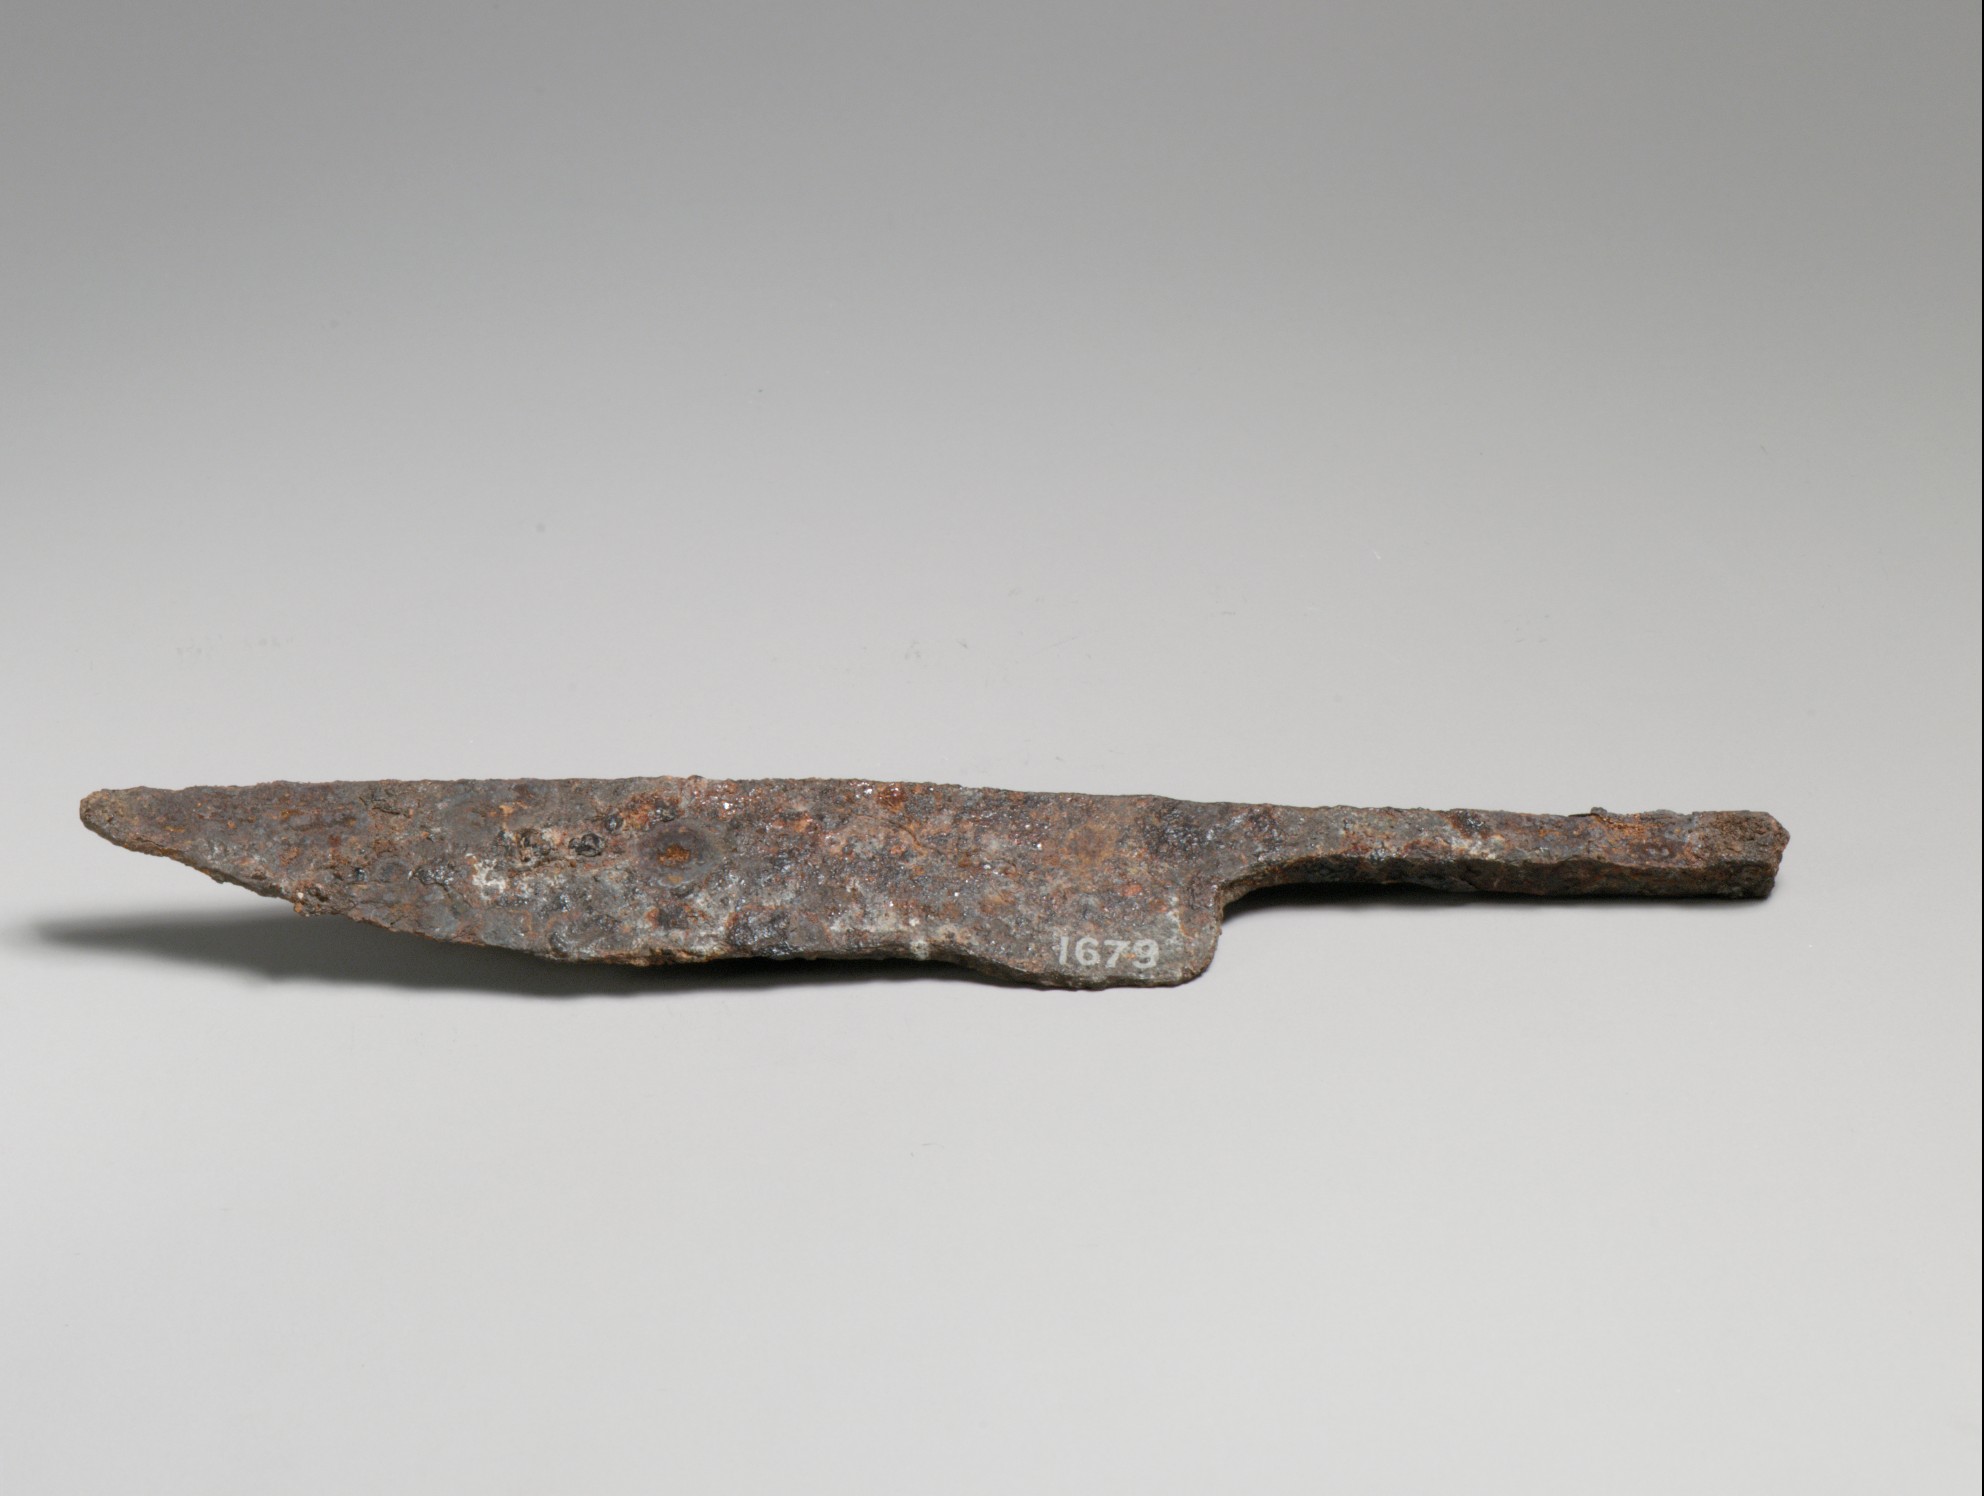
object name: knife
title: Knife blade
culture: etruscan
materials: iron